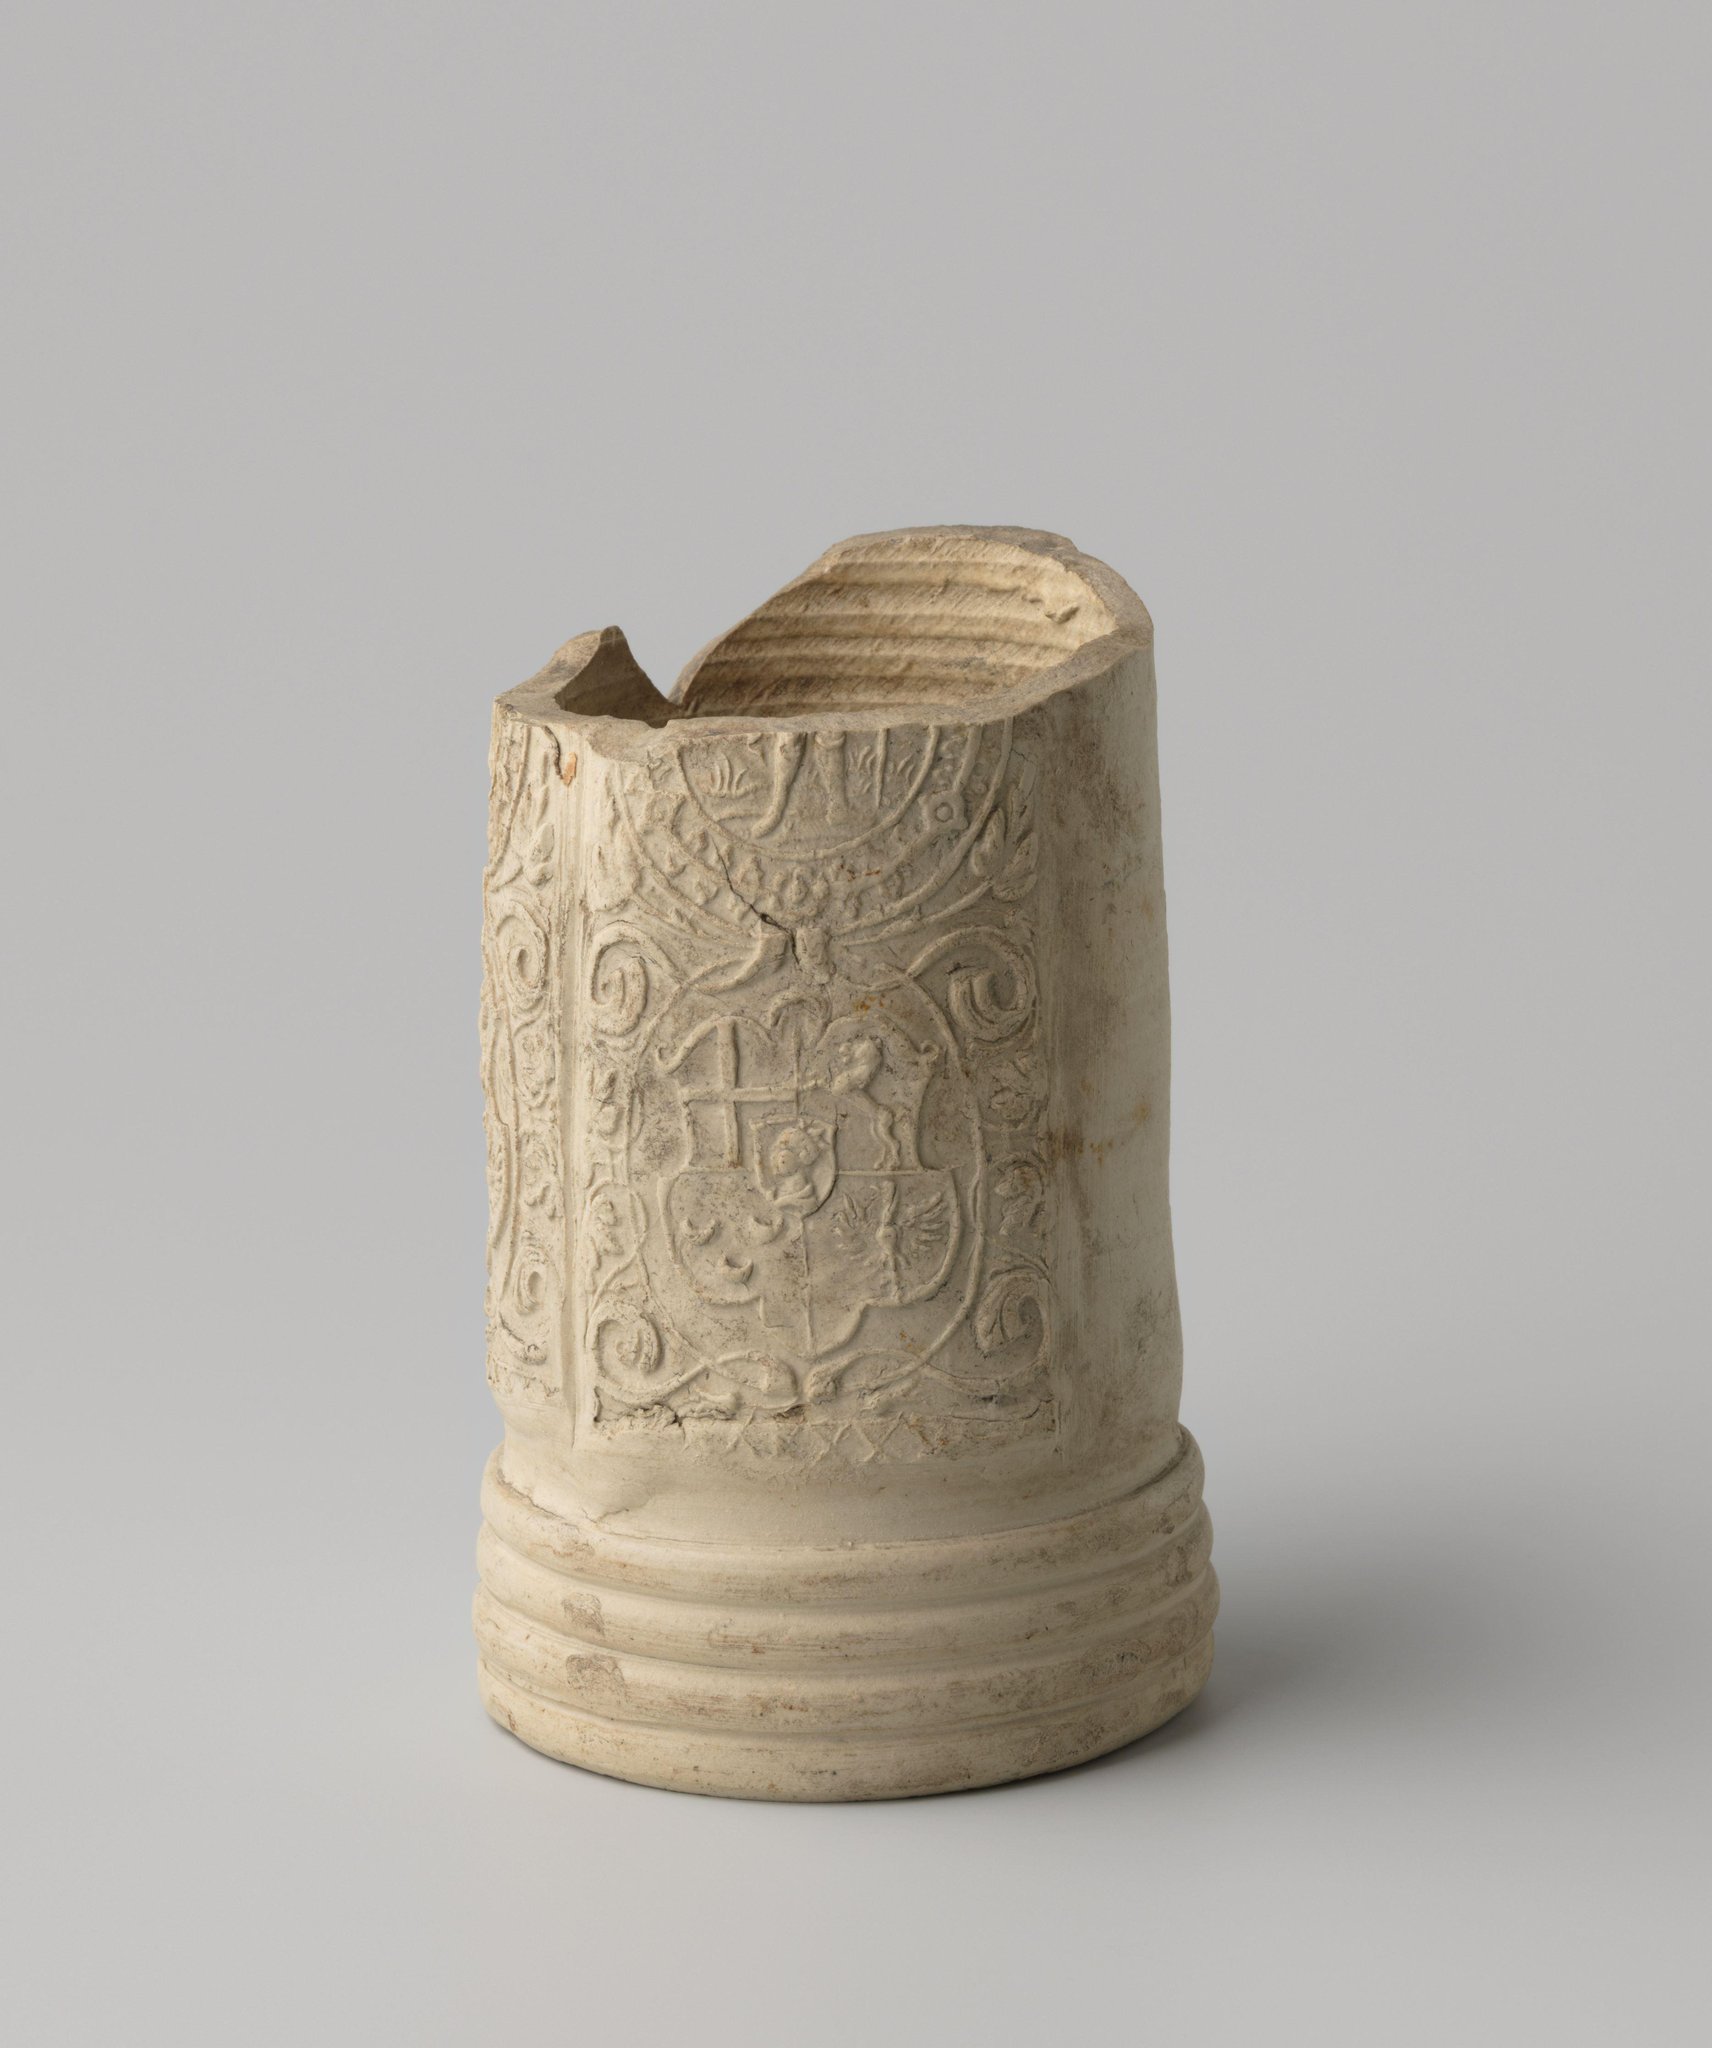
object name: schnelle, snel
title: Fragment of a tankard (schnelle) with a coat of arms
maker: Anonymous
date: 1575-1599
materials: glaze, stoneware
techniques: firing, forming, relief, turning, vitrification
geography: siegburg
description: Fragment van een kruik (schnelle) van steengoed met cilindervormig, taps toelopend lichaam. Bovenzijde en oor ontbreken. Profielen boven de voet. Op het lichaam in reliëf driemaal een gedrukt en opgelegd, langwerpig vak met een wapen omgeven door bladranken. Boven het wapen nog half zichtbaar een medaillon met een Romein in een landschap omgeven door een bloemrank. Siegburg.